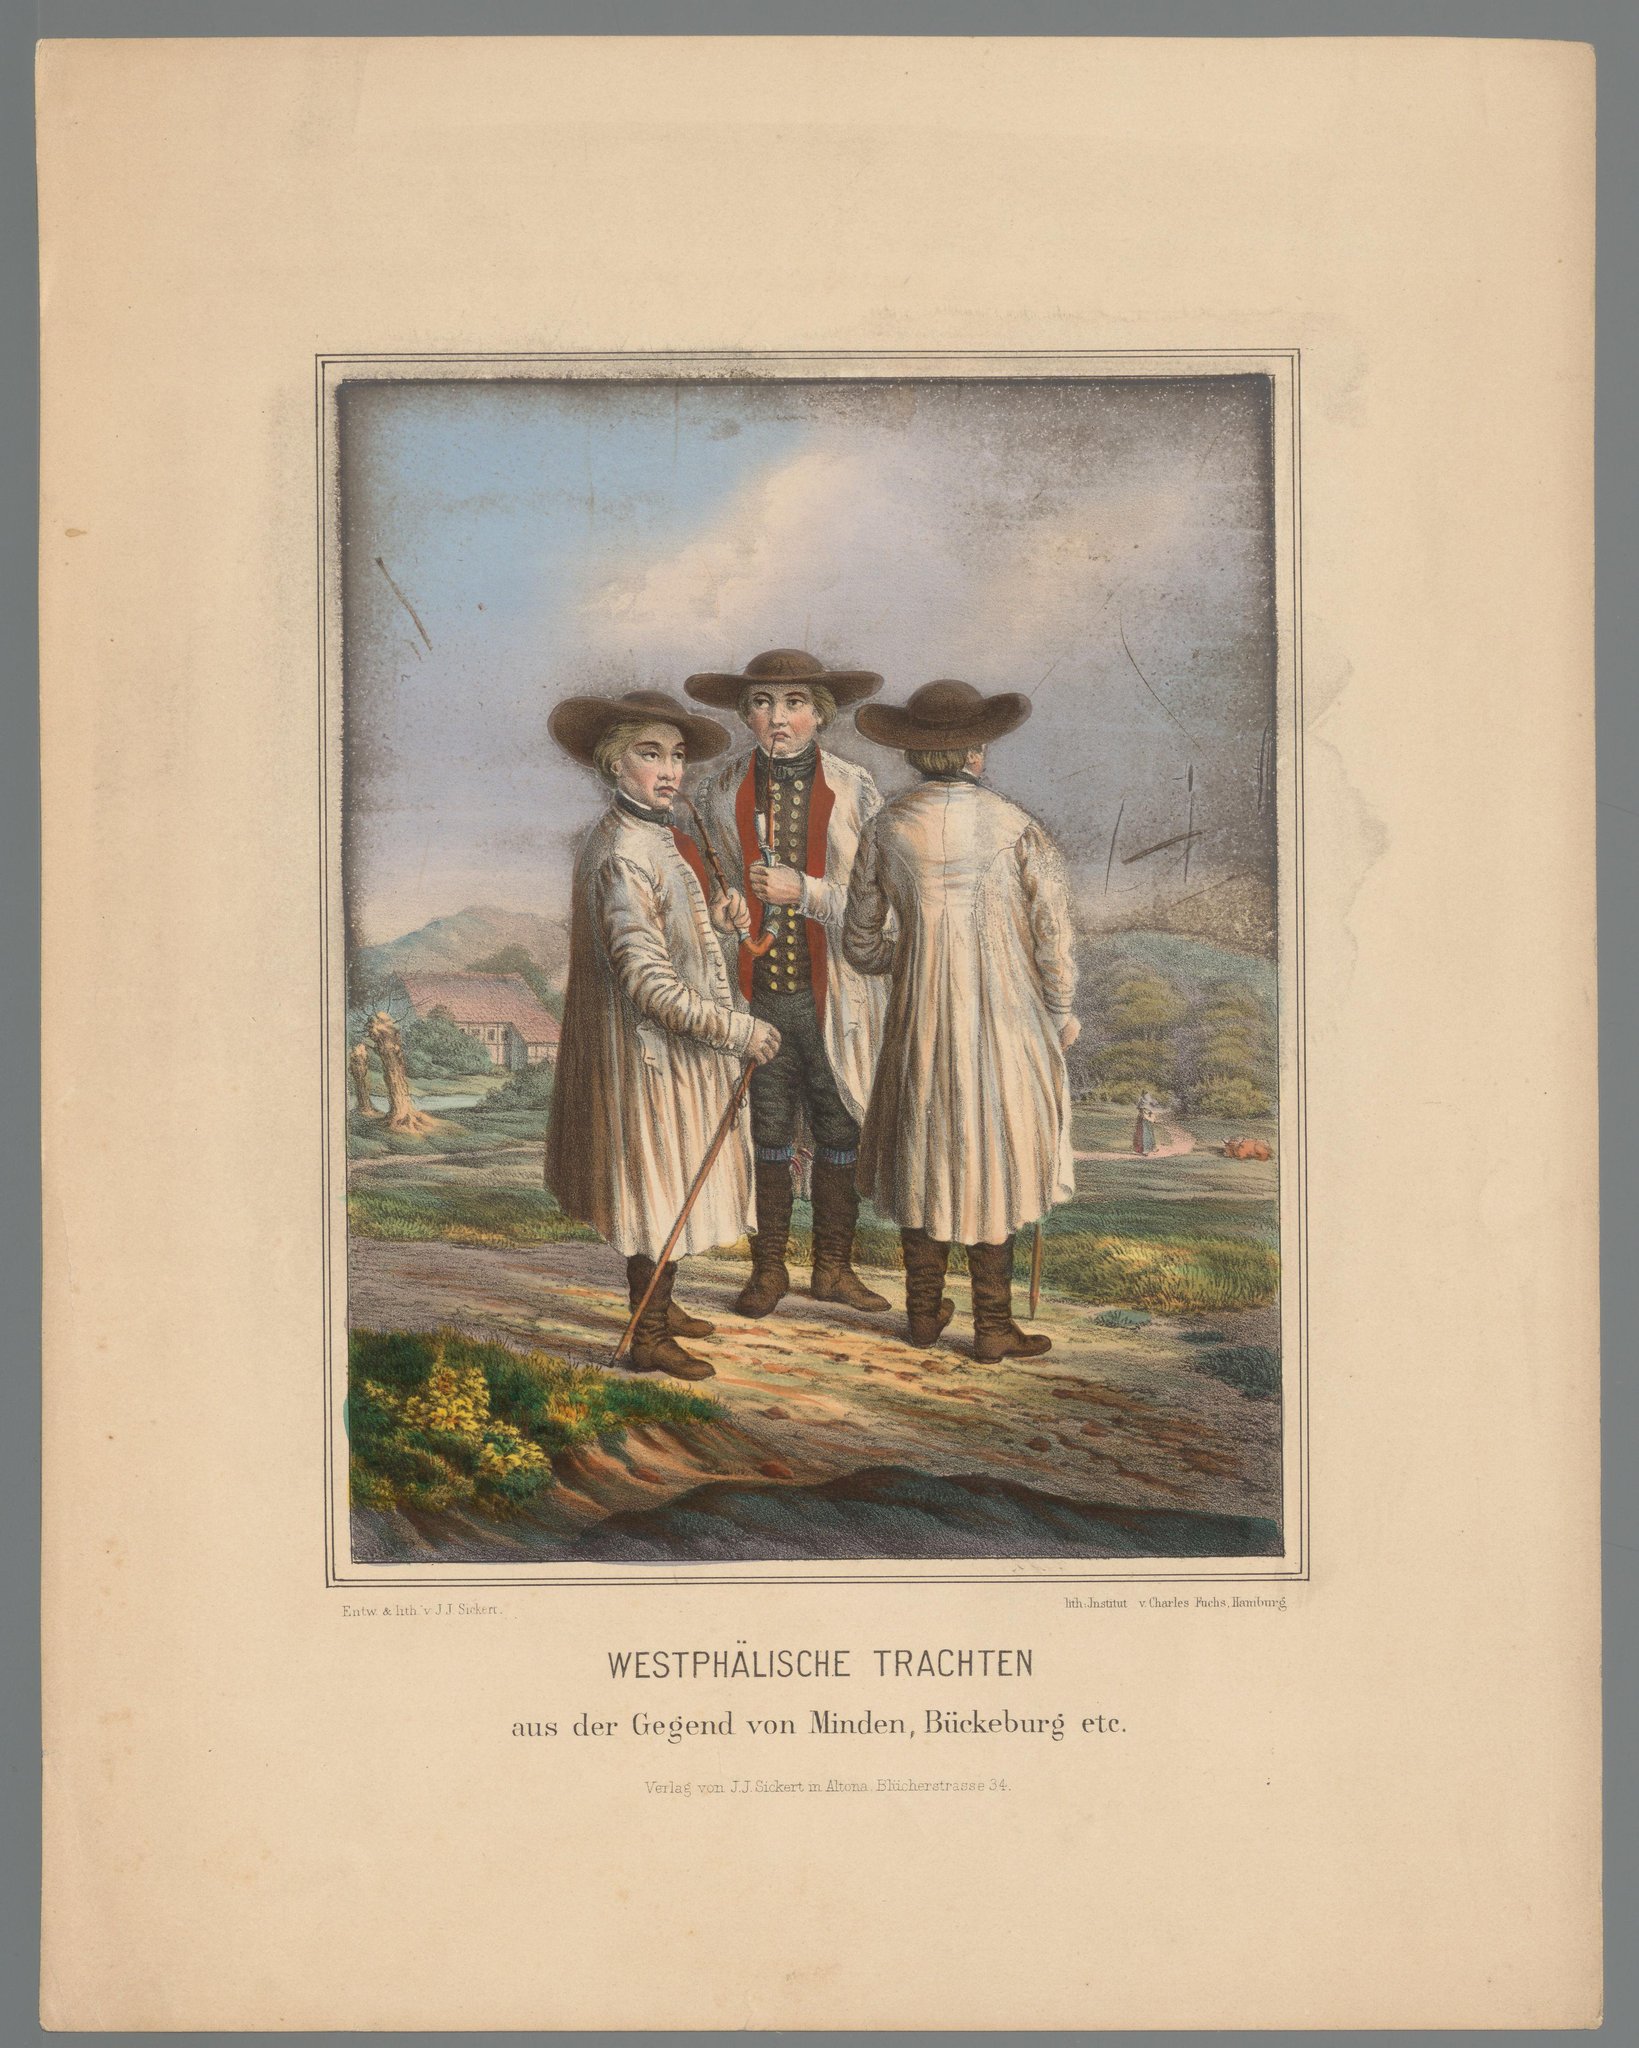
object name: print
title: Drie mannen in Westfaalse klederdracht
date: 1813-1864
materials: paper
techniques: hand coloring, lithograph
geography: hamburg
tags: adult man (+ three persons), pipe ~ tobacco, folk costume, regional costume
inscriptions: collector's mark: Lugt 2228